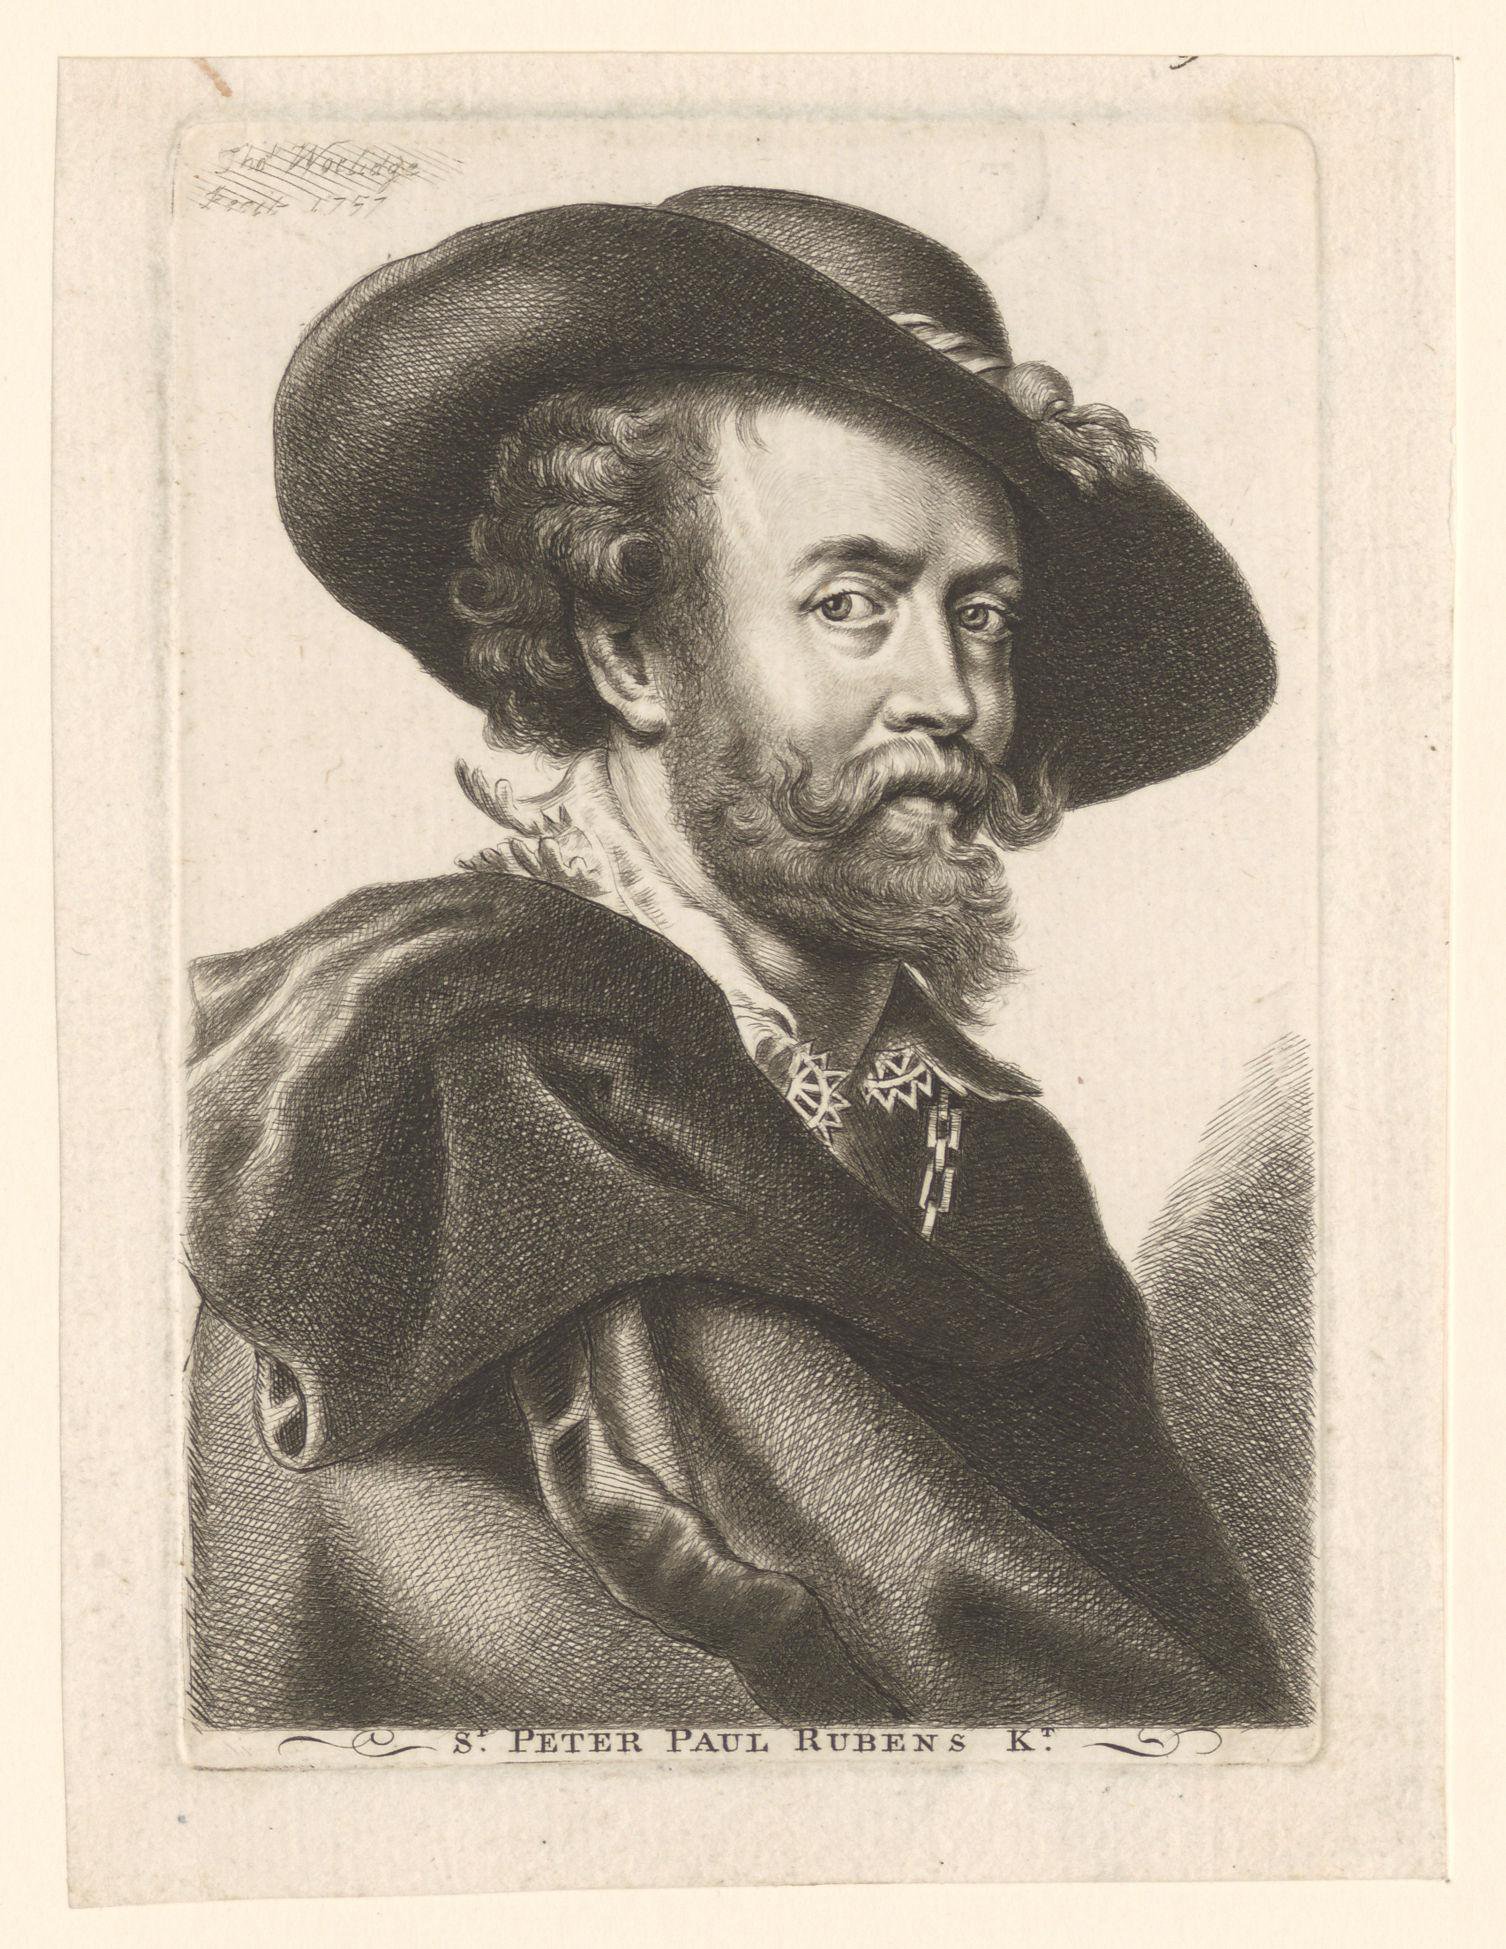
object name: print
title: Portret van Peter Paul Rubens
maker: thomas worlidge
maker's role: print maker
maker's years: 1700-1766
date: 1757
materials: paper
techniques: drypoint, etching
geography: london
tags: antwerp, painter, print maker, draughtsman, peter paul rubens, historical person (...) - historical person (...) portrayed alone, portrait, self-portrait of artist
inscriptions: collector's mark: Lugt 2760, collector's mark: Lugt 2228